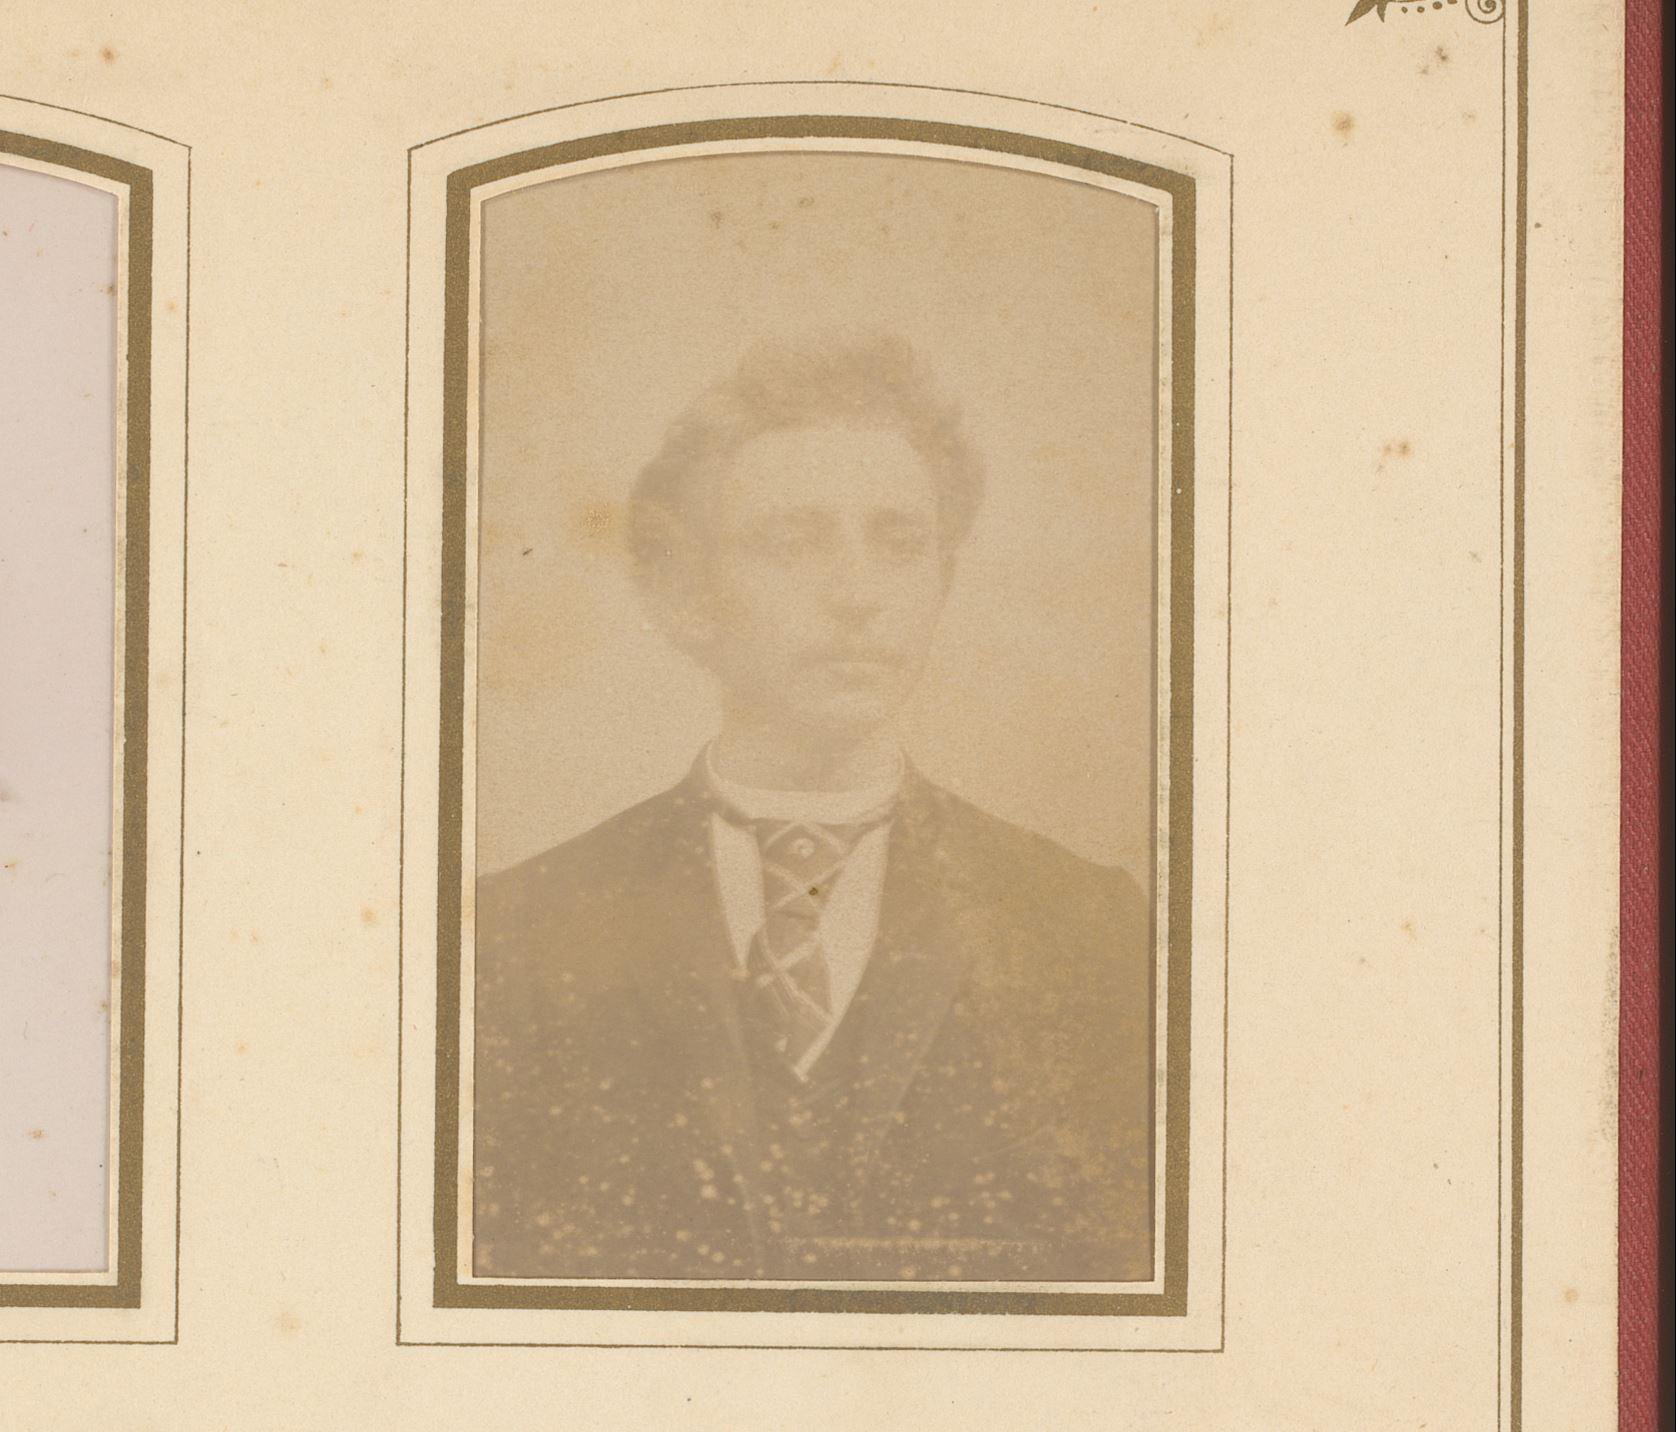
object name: album leaf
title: Portret van een man met stropdas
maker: Anonymous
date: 1860-1900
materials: cardboard, photographic support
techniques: albumen print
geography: netherlands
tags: historical persons